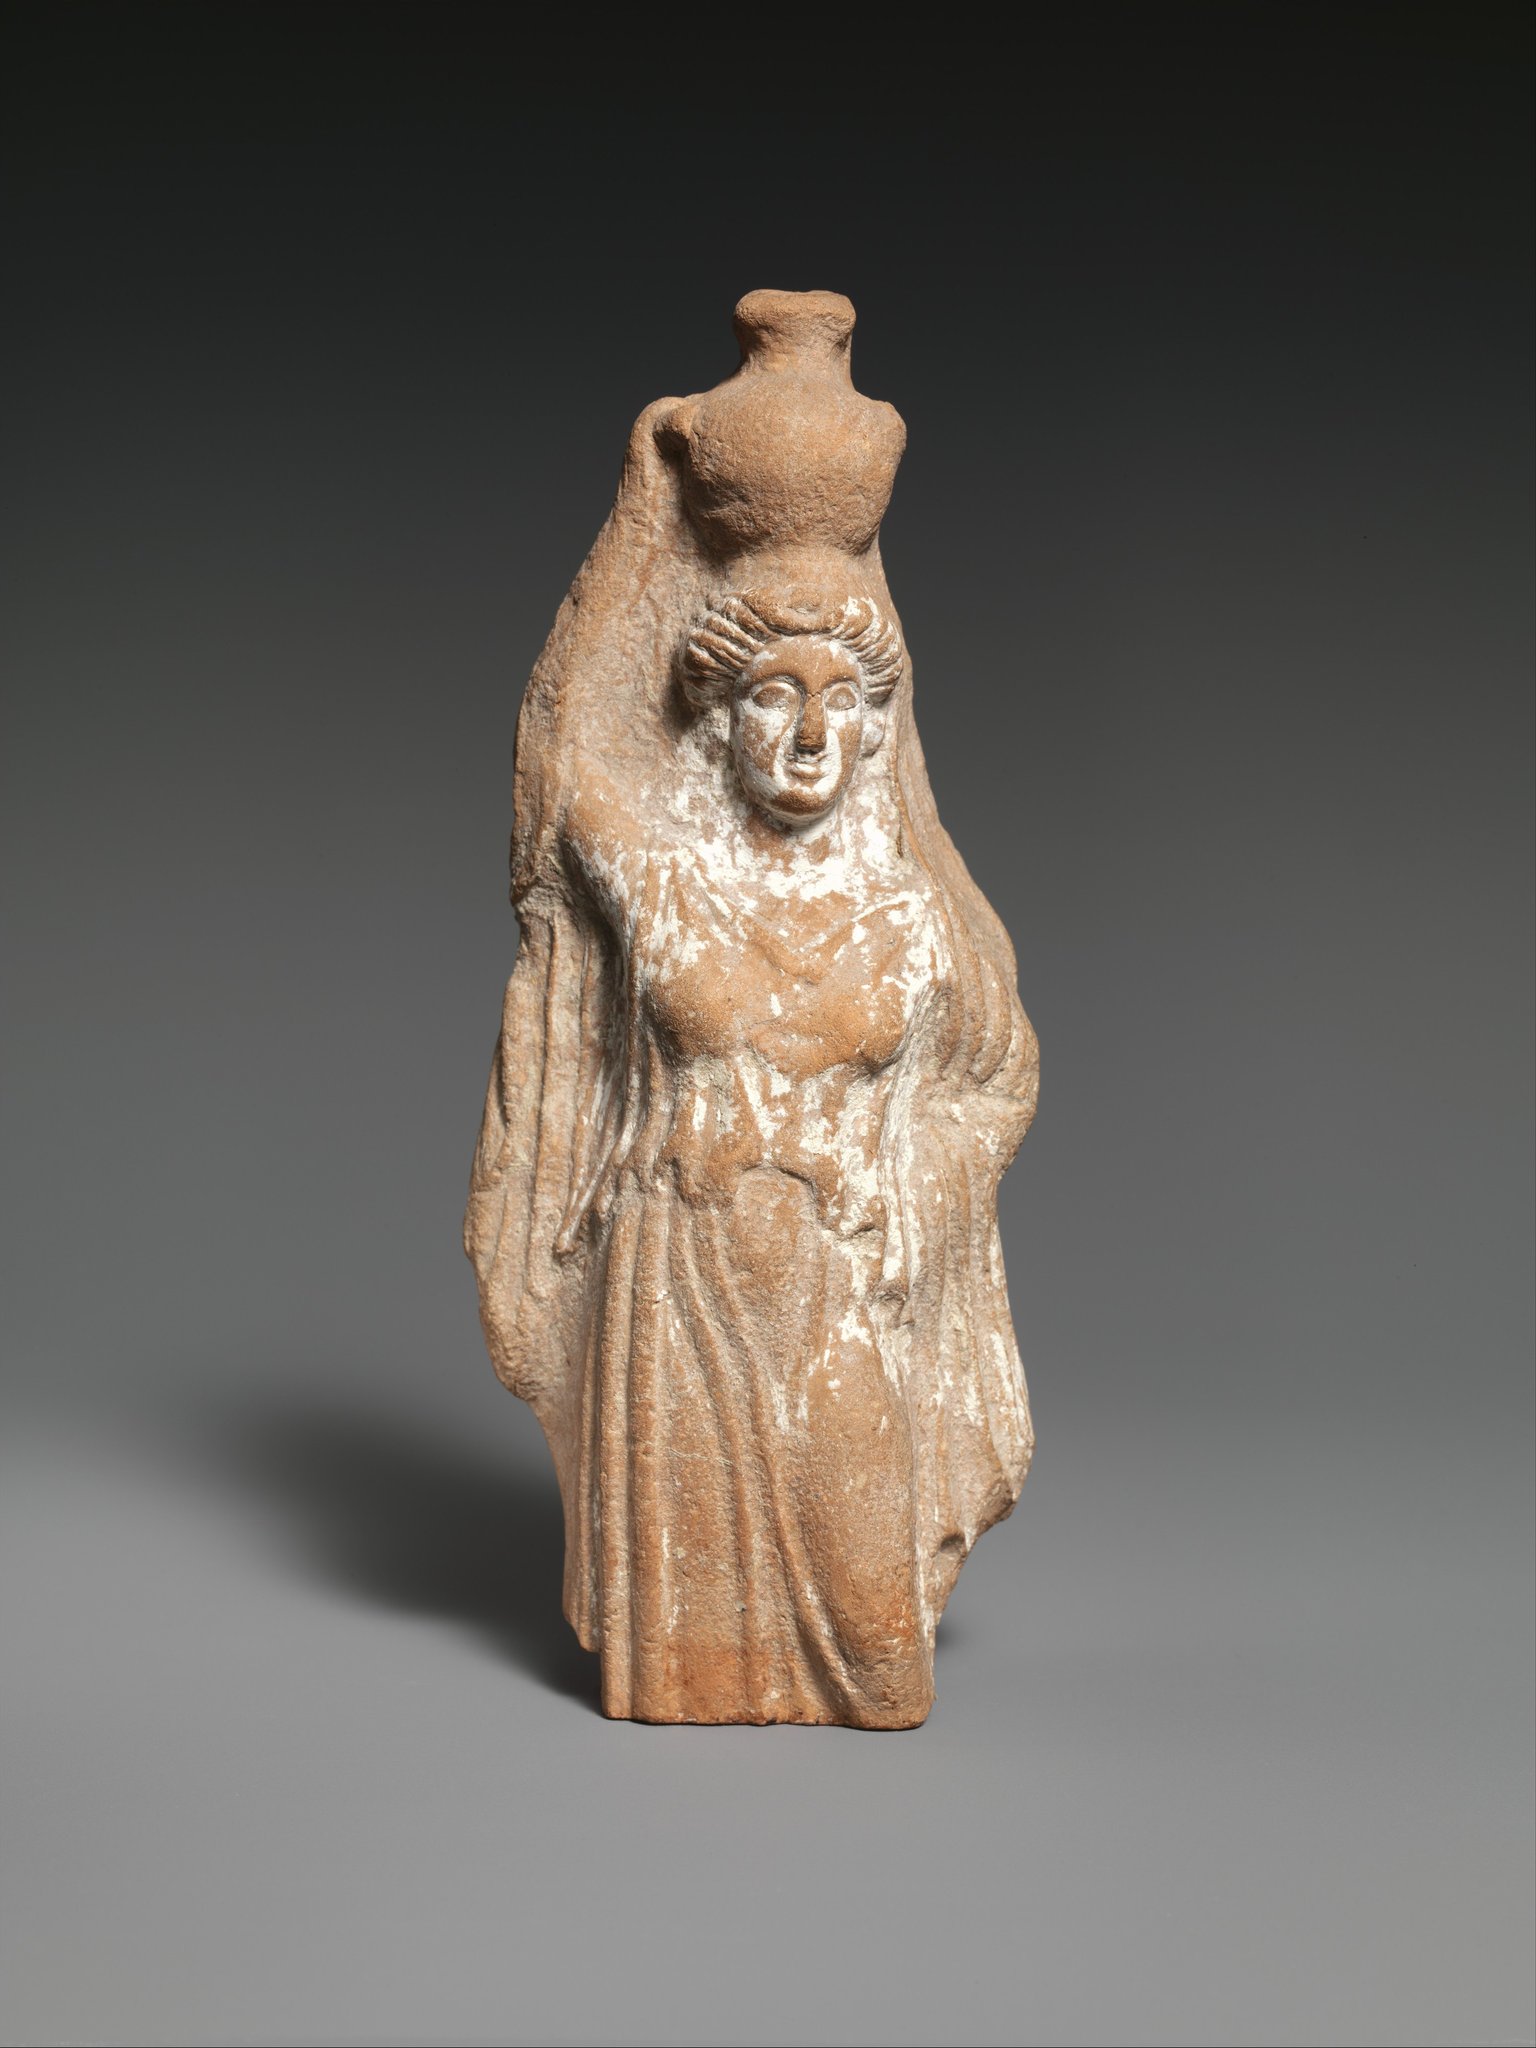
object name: statuette of a female votary carrying a hydria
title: Terracotta statuette of a female votary carrying a hydria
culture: cypriot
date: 434-301 BCE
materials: terracotta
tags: women